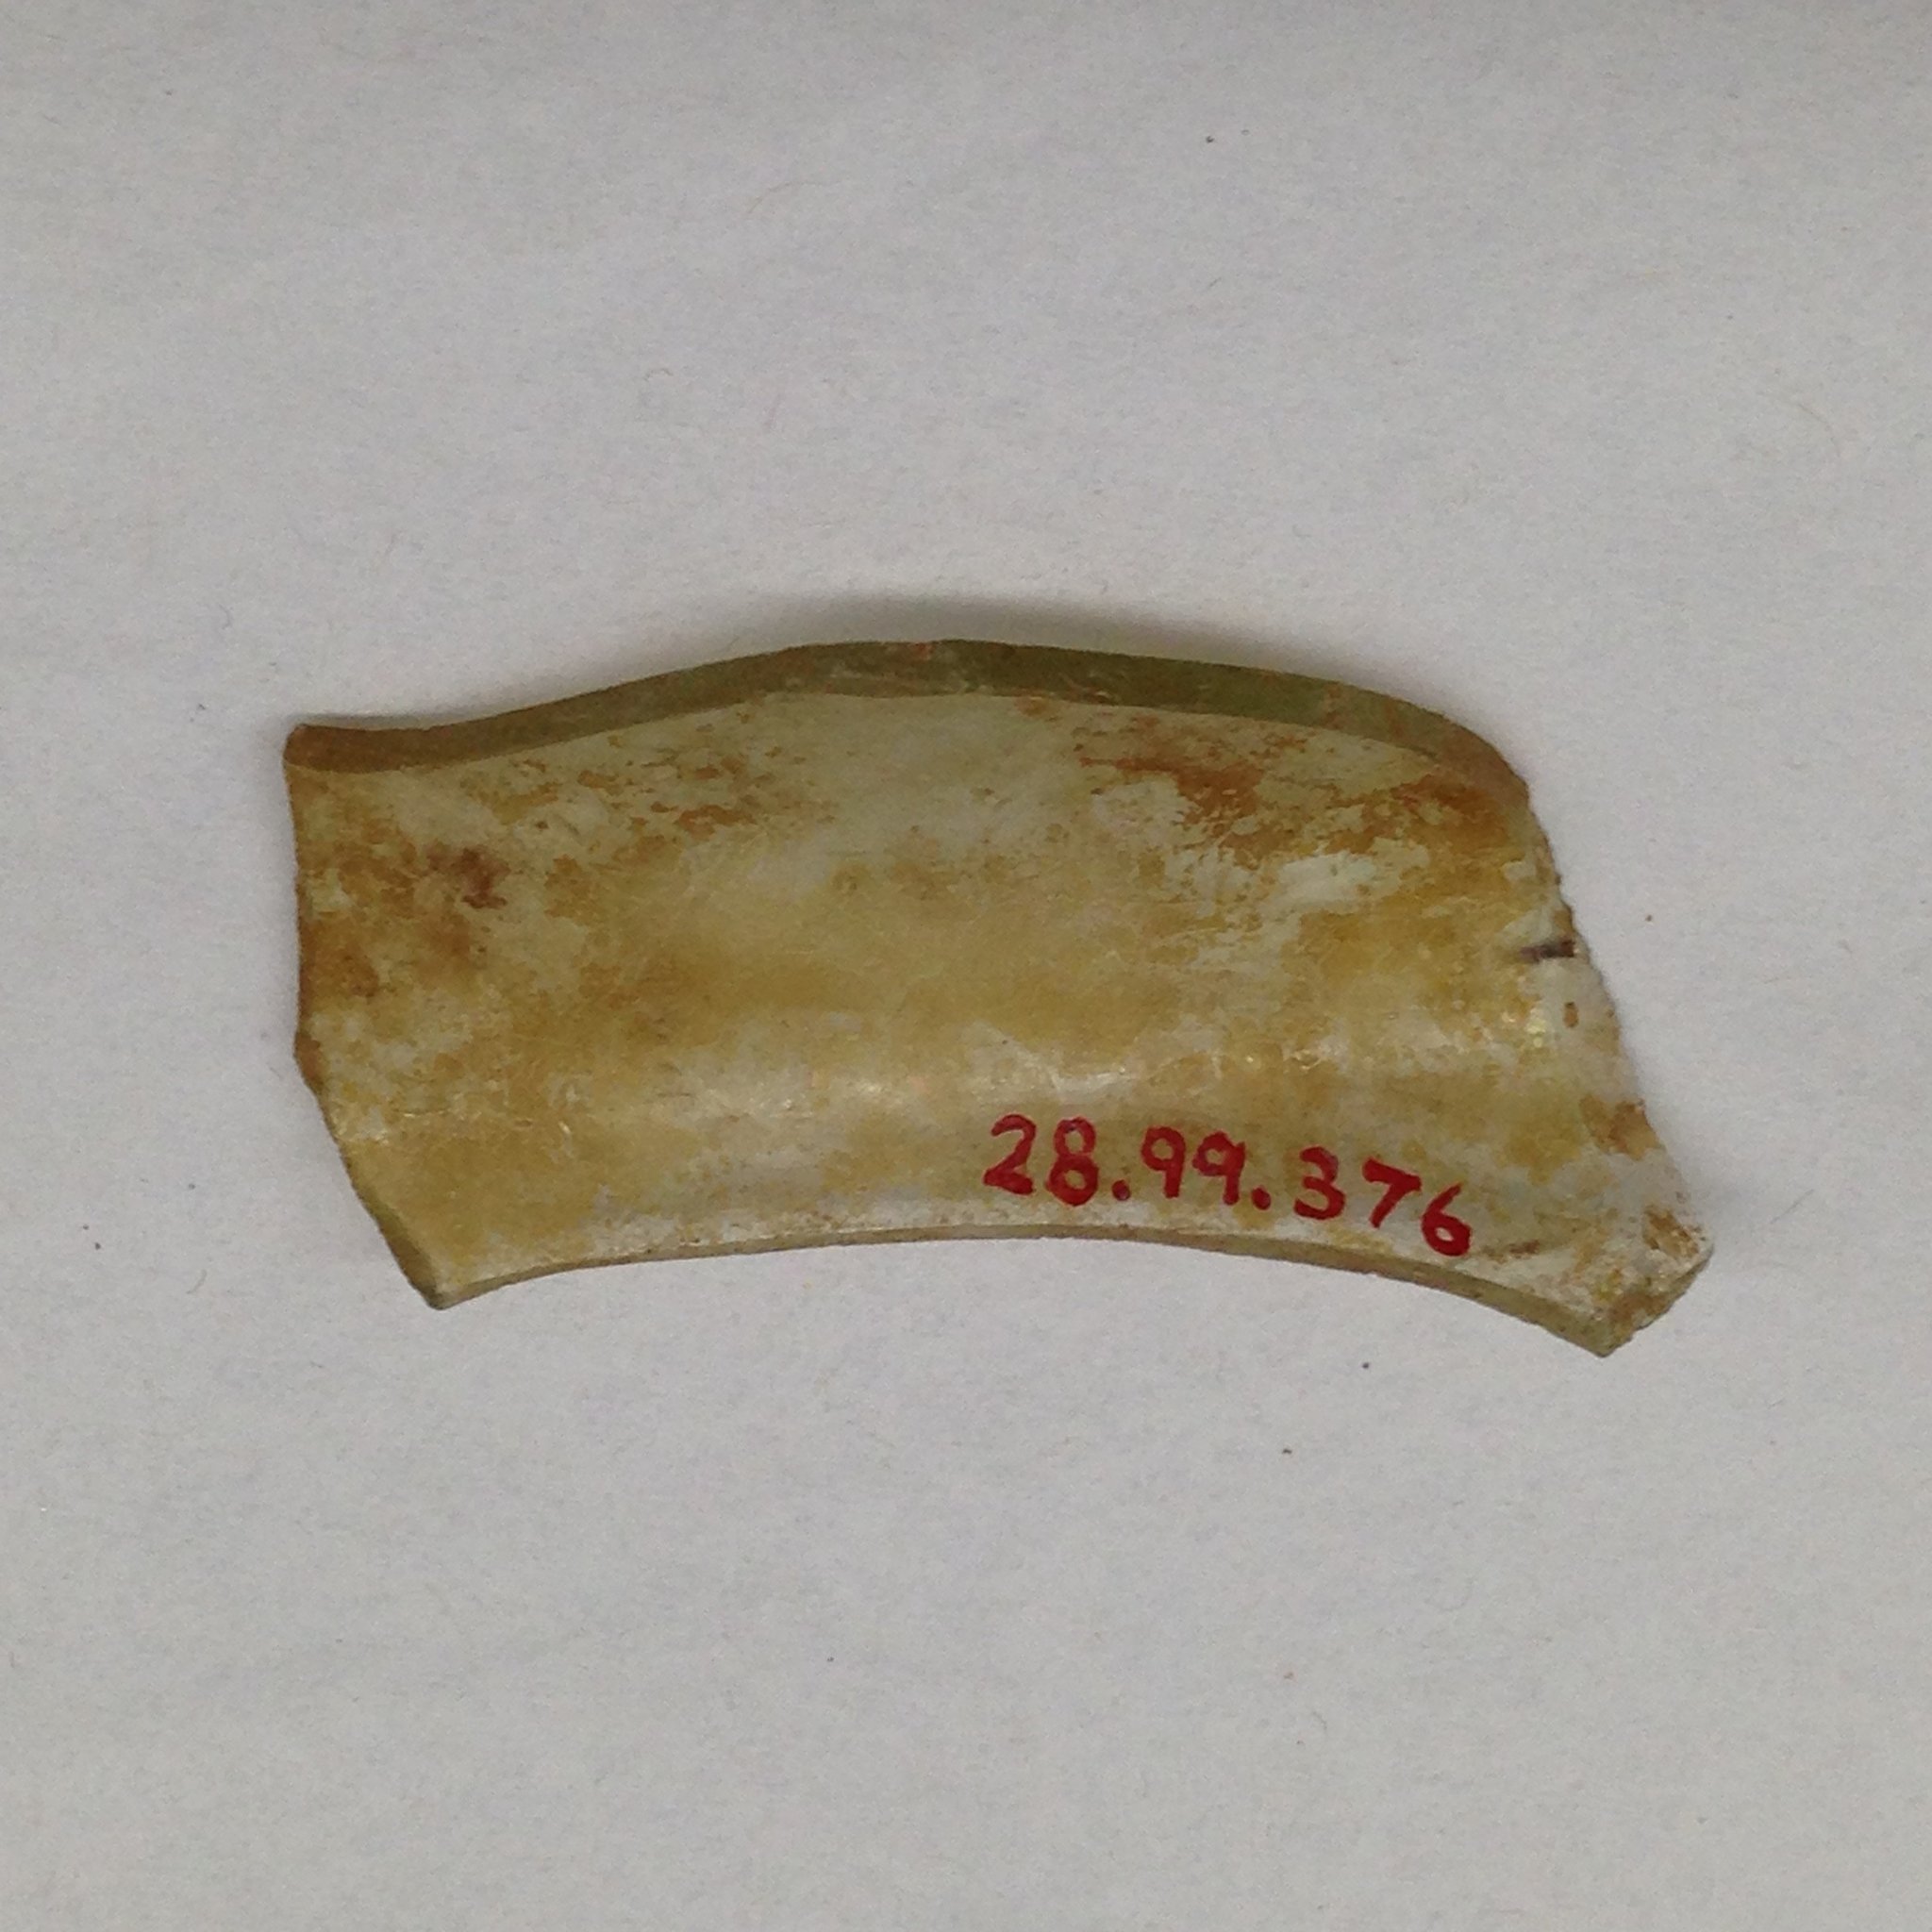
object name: fragment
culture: european or middle eastern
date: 1150-1250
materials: ceramic, glass